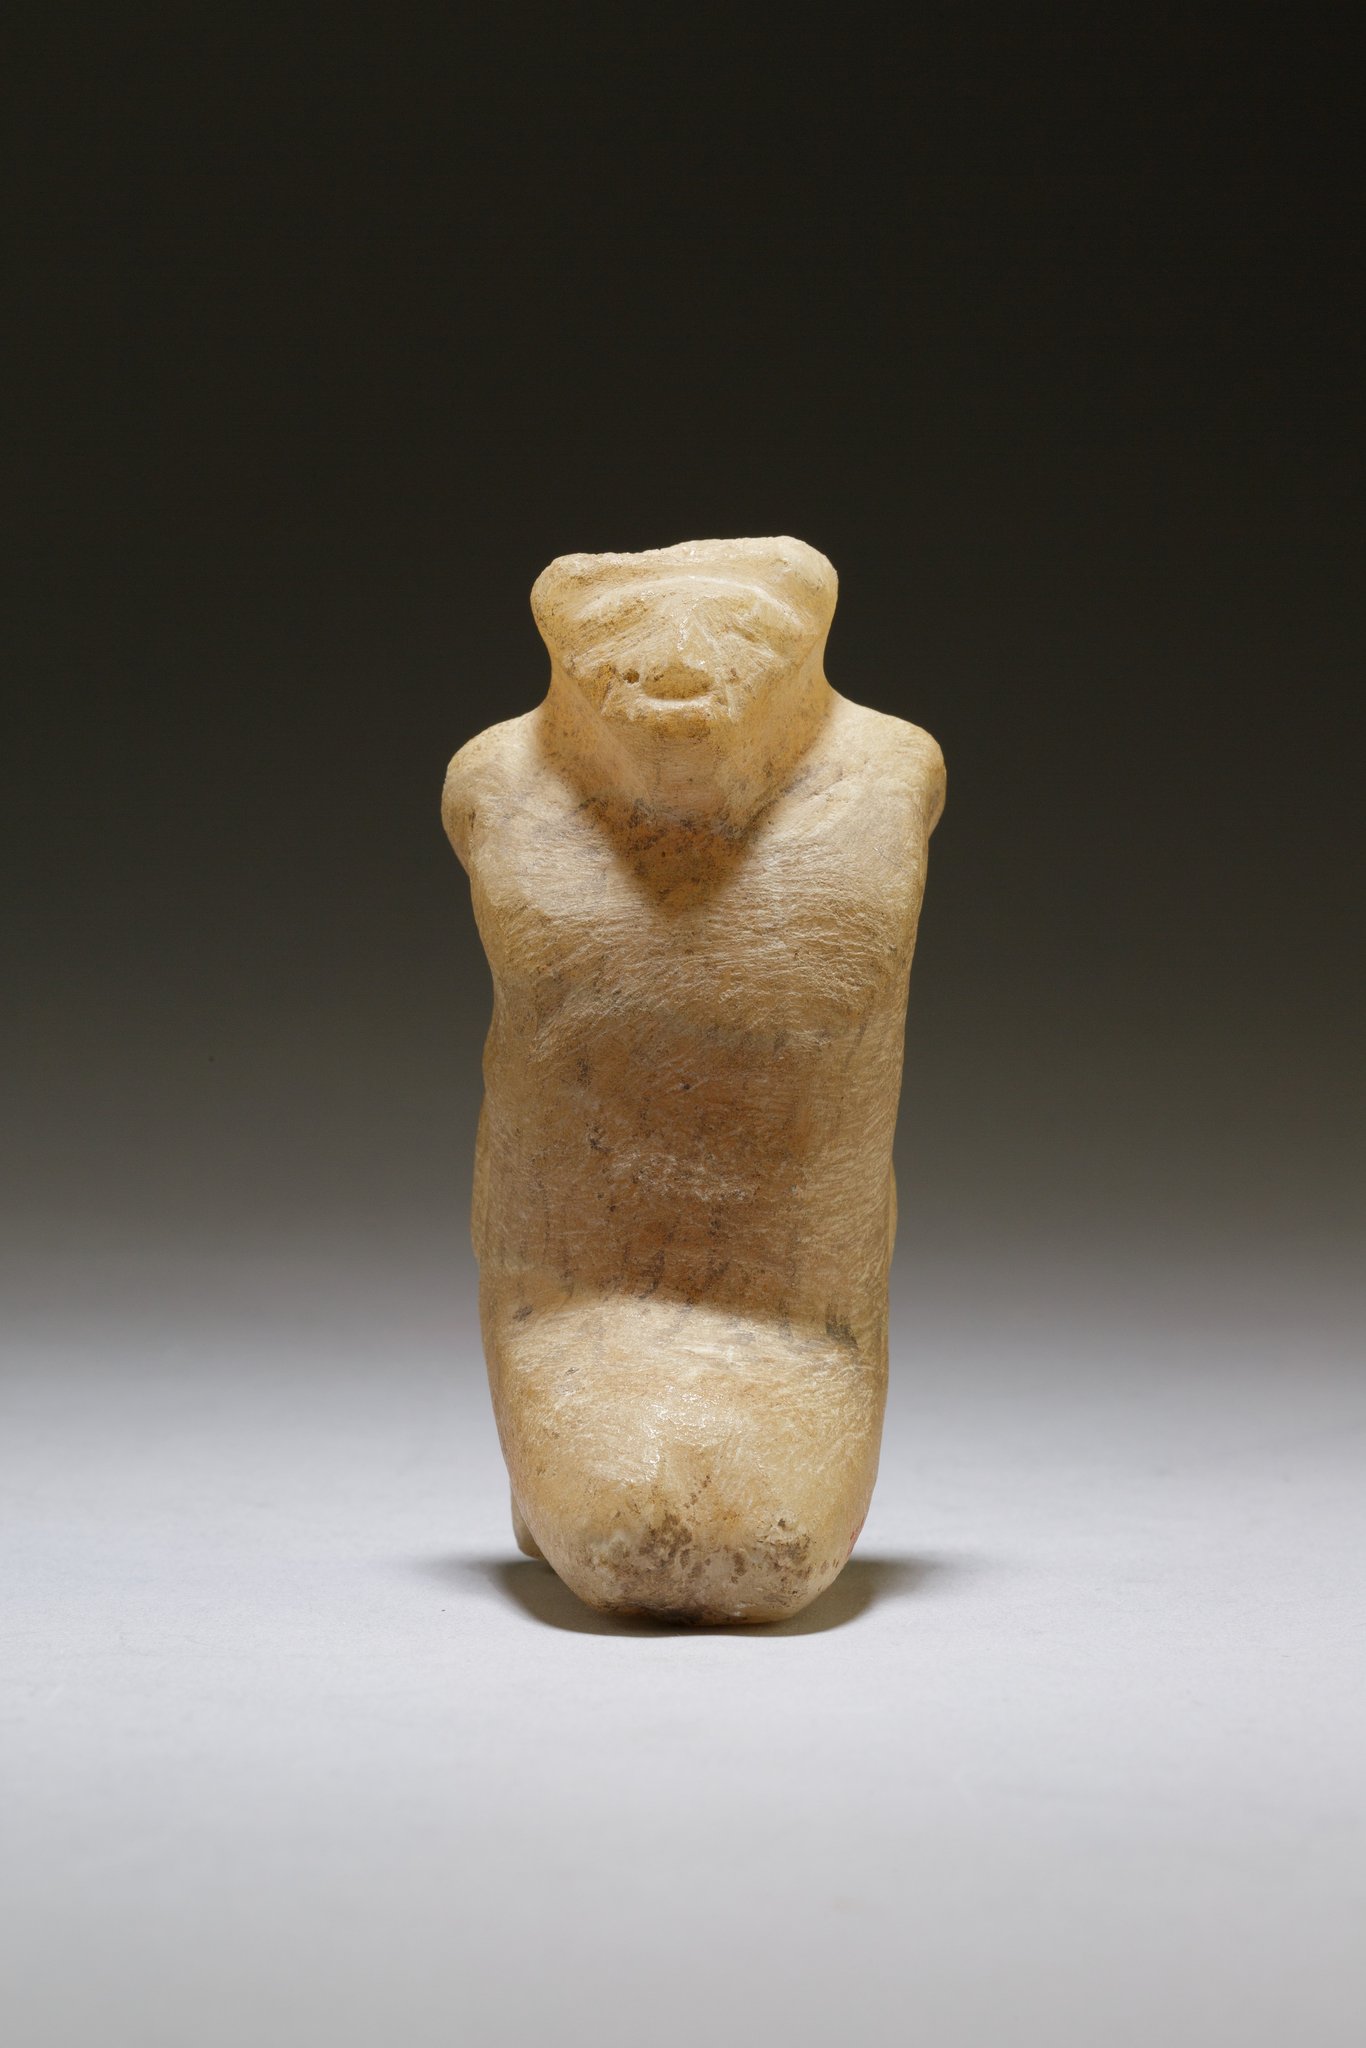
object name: figure, human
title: Magical figure of captive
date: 1981-1650 BCE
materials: stone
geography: egypt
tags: human figures